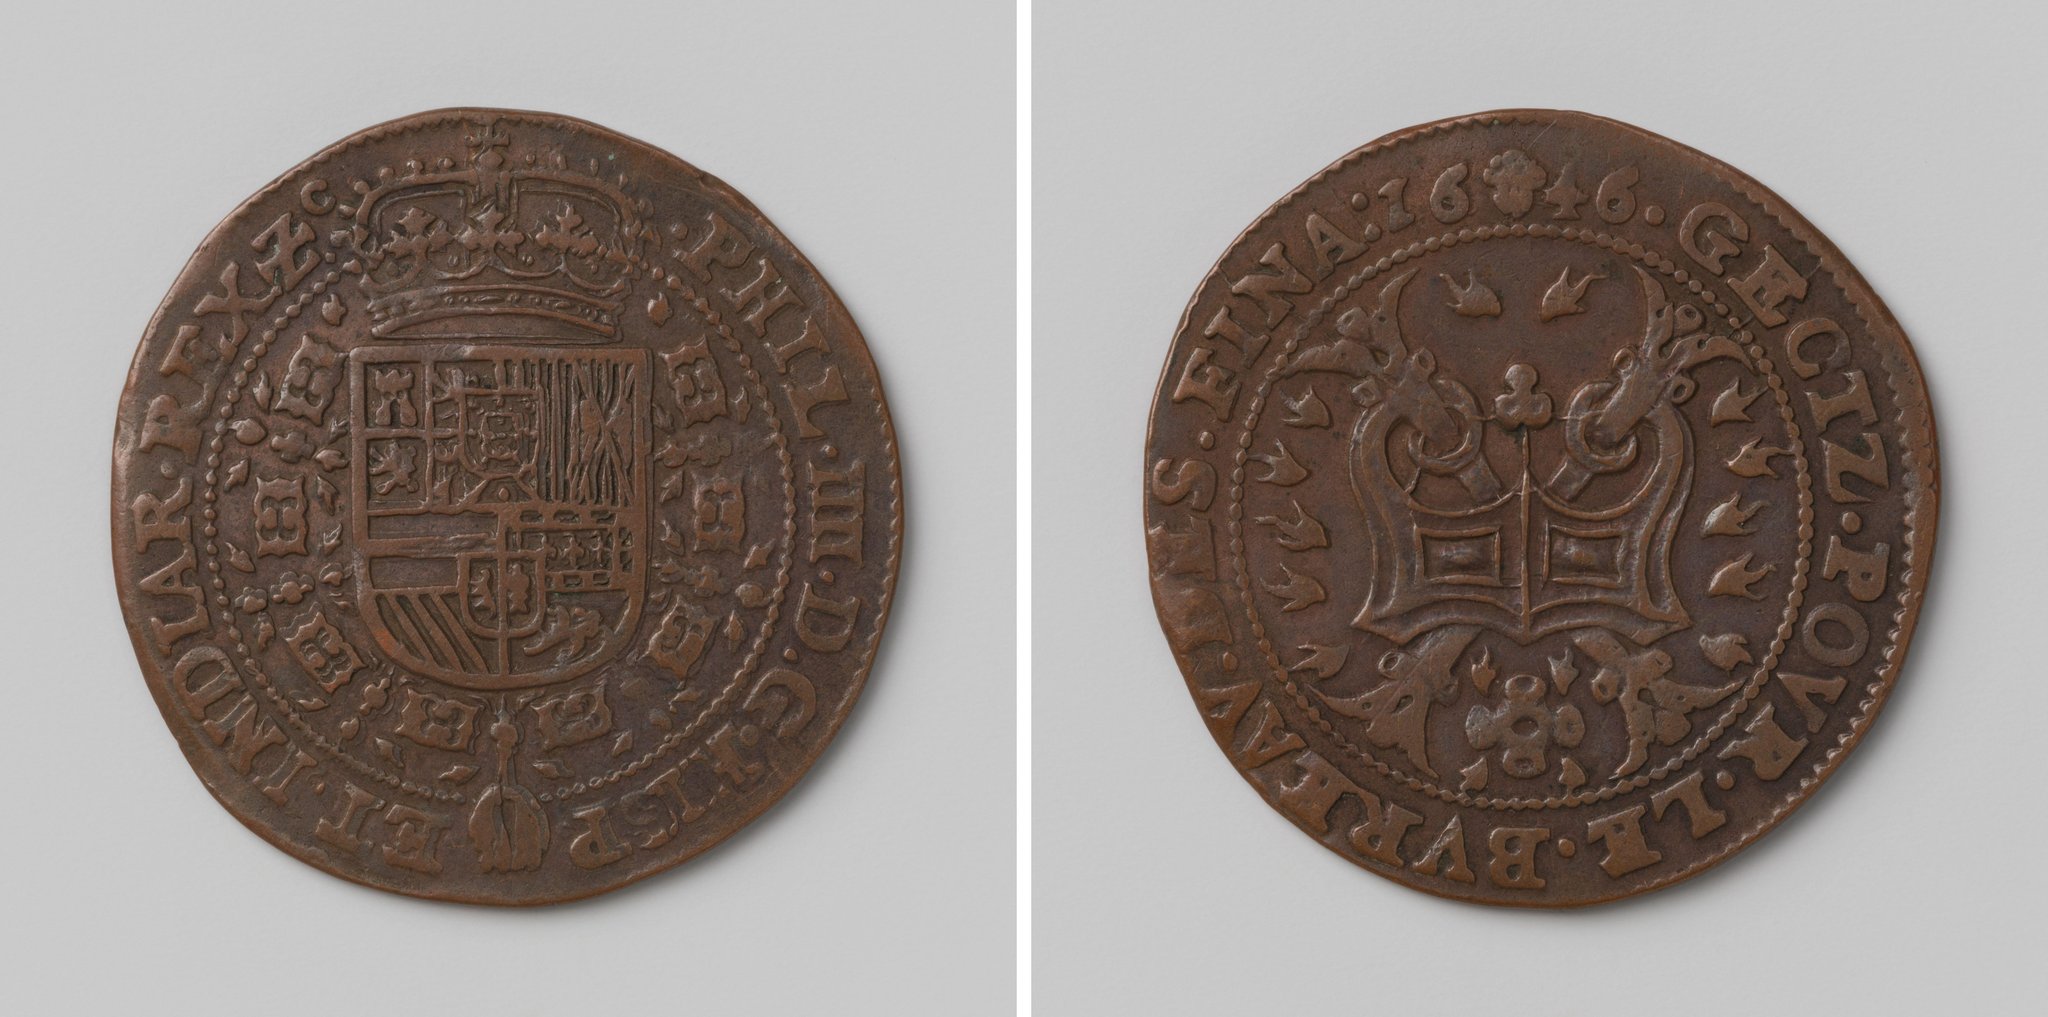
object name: jeton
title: Filips IV, koning van Spanje, rekenpenning geslagen op last van de raad van Financiën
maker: Anonymous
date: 1646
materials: copper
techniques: striking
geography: brussels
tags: filips iv (koning van spanje)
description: Koperen penning. Voorzijde: gekroond wapenschild, omhangen met de orde van het Gulden Vlies binnen omschrift. Keerzijde: Bourgondisch kruis, omgeven door vonken; daaronder: vuurslag, waar vonken uitschieten binnen omschrift